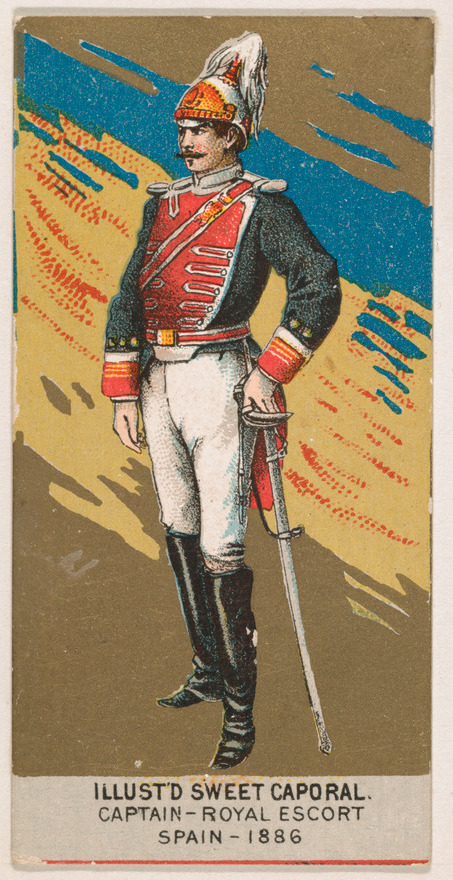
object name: print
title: Captain, Royal Escort, Spain, 1886, from the Military Series (N224) issued by Kinney Tobacco Company to promote Sweet Caporal Cigarettes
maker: kinney brothers tobacco company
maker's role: publisher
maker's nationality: american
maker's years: 1869-2011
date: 1888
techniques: color lithograph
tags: military,swords,men